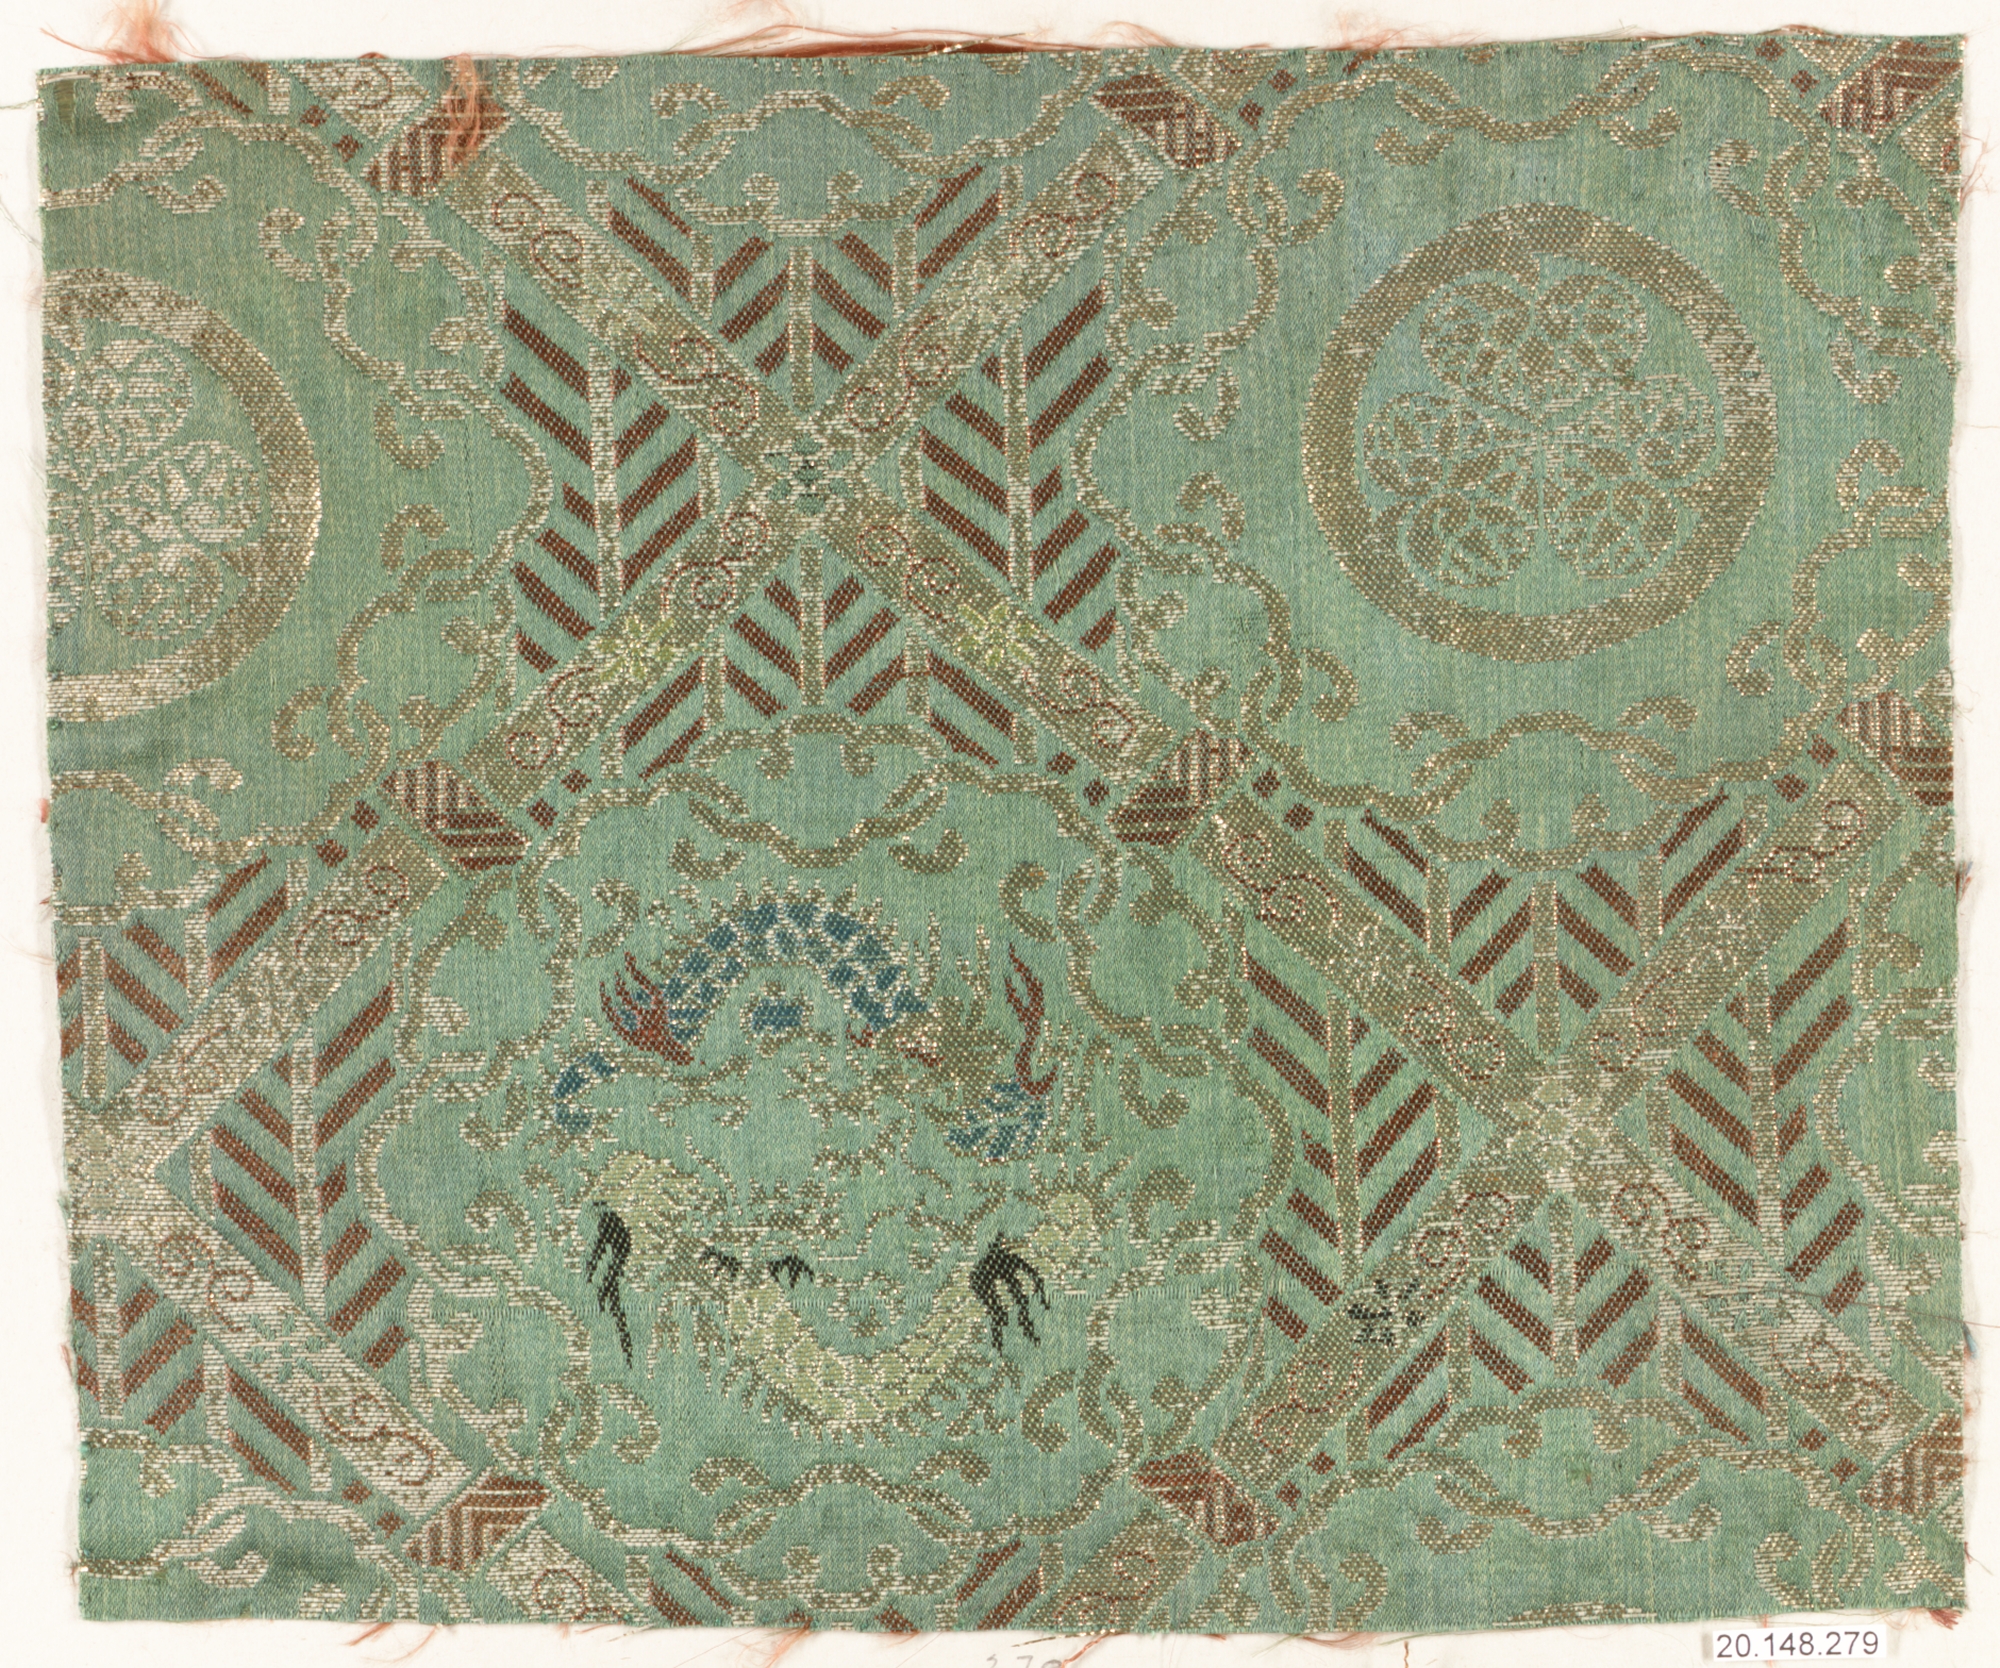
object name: piece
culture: japanese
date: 1701-1800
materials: silk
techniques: compound weave